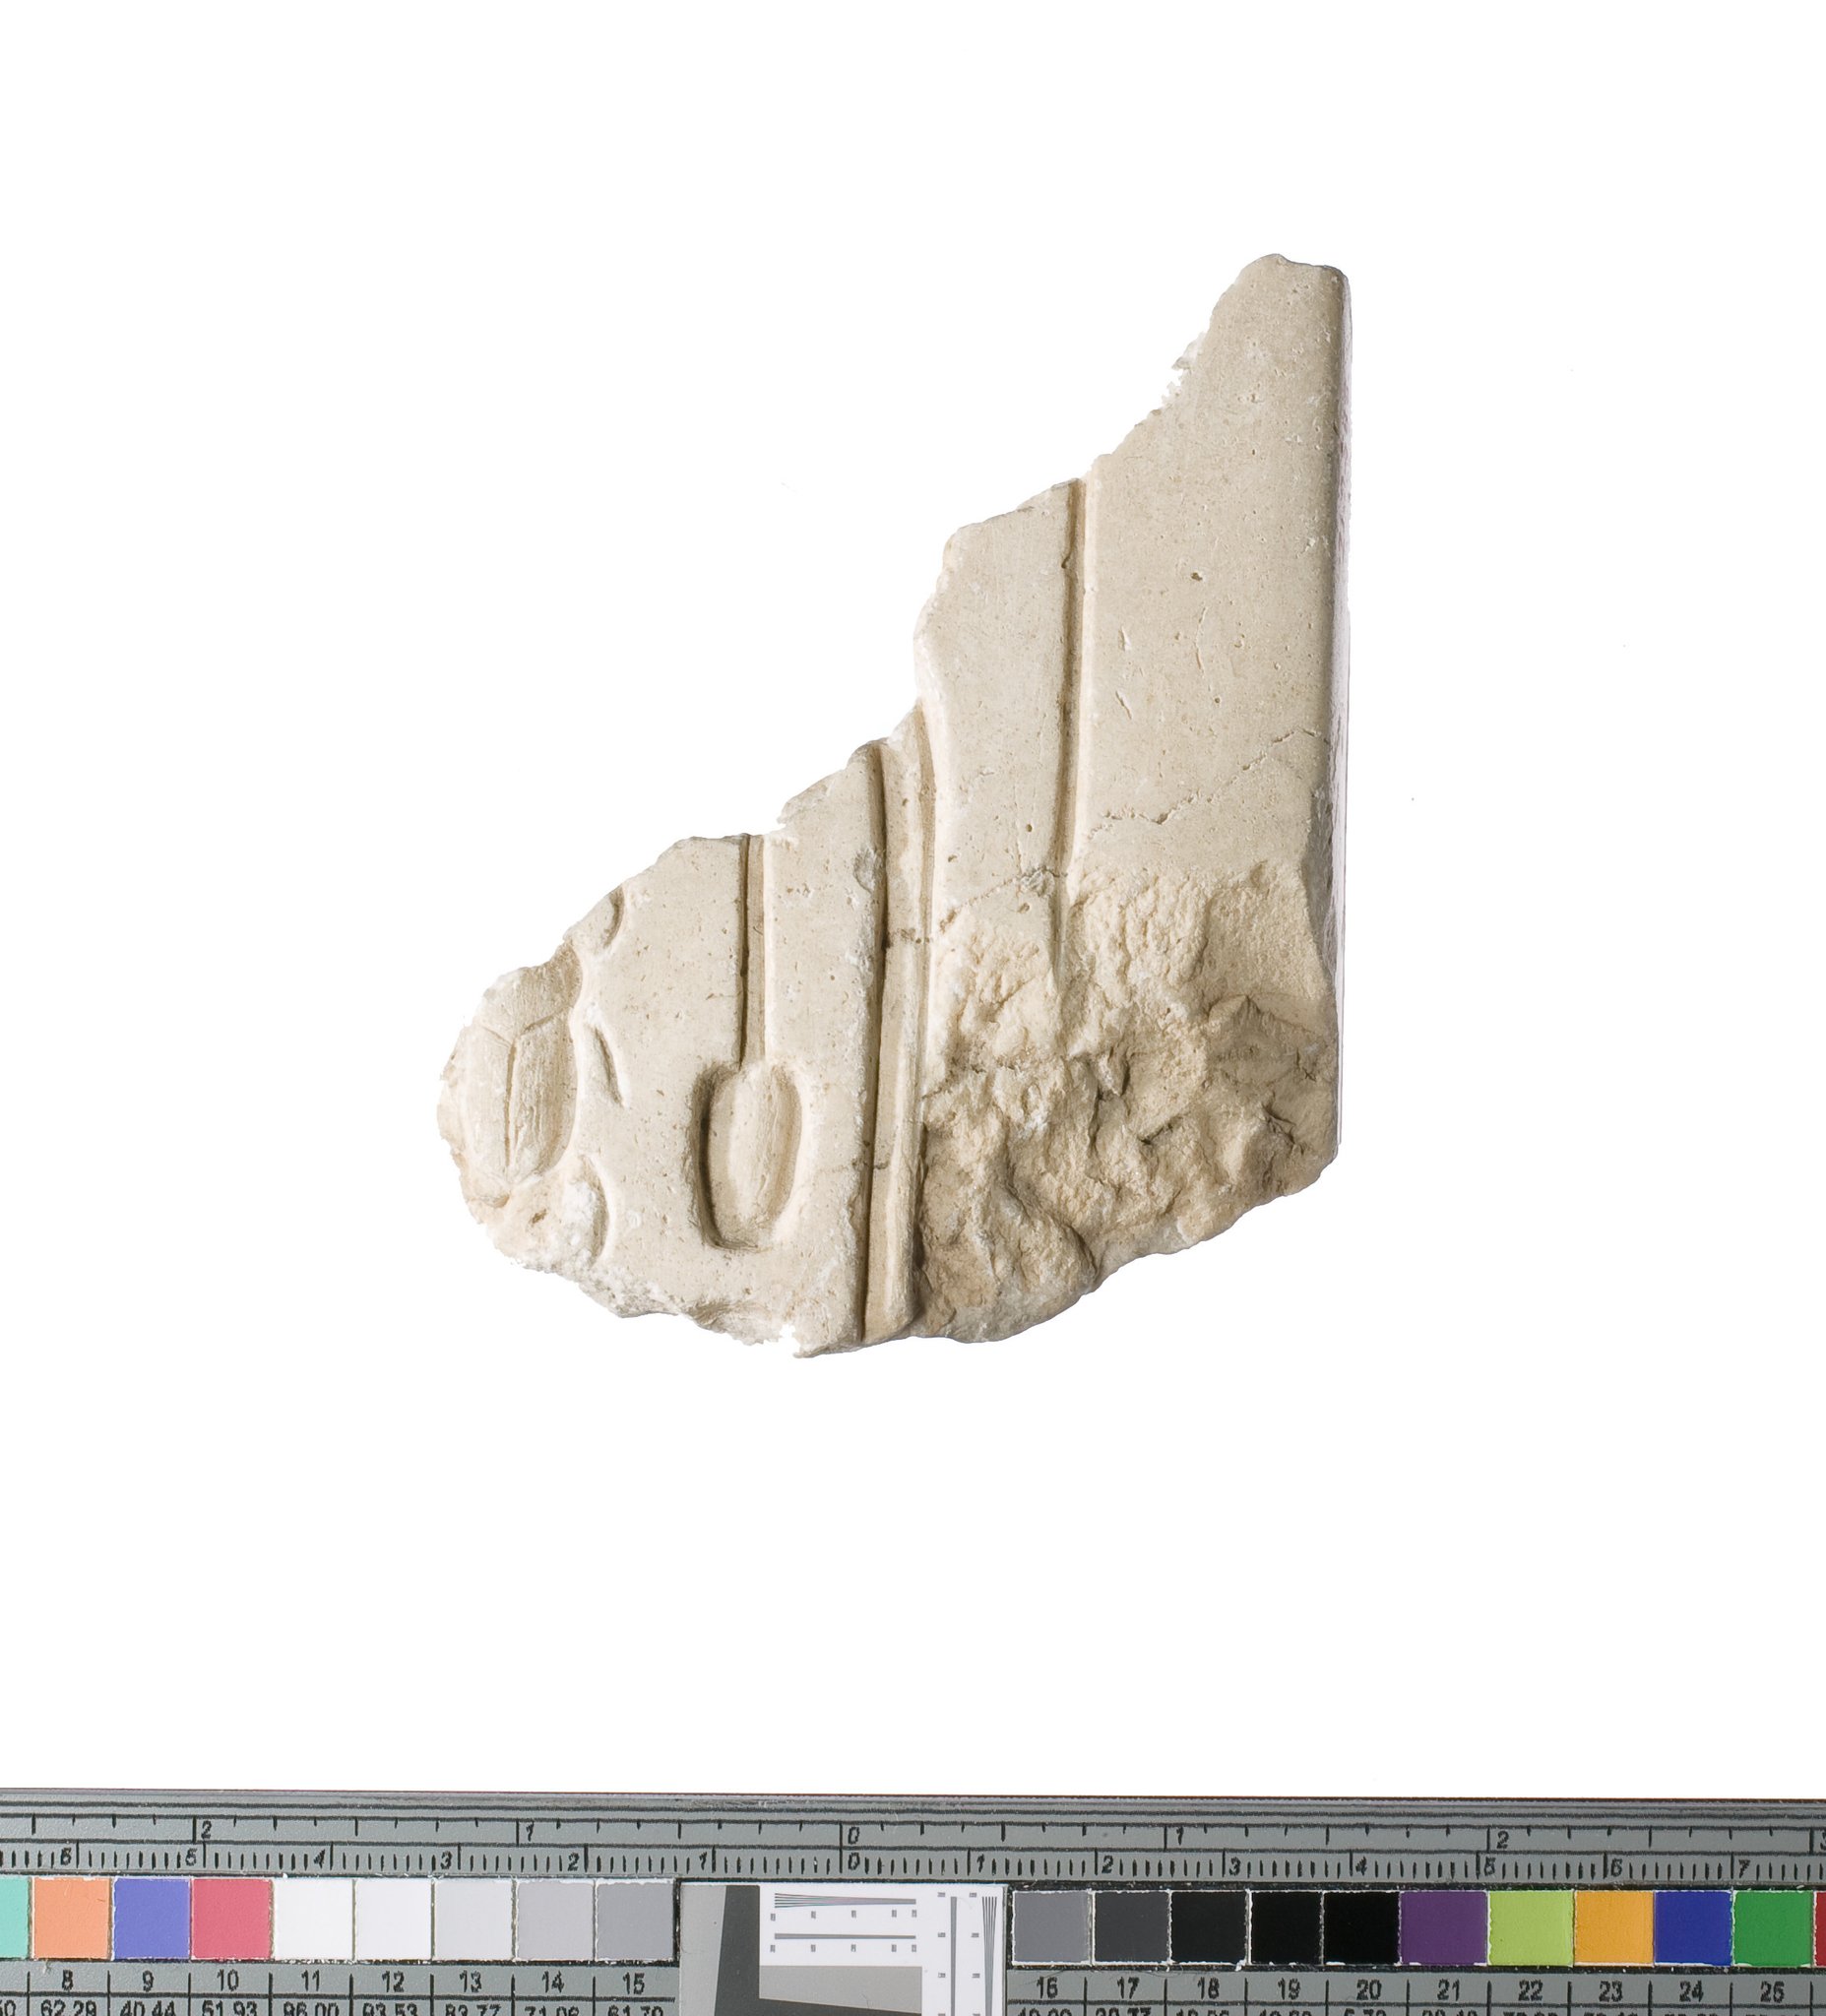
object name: inscribed corner element, aten cartouche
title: Inscribed corner, Akhenaten prenomen on one surface, Aten cartouche on other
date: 1353-1336 BCE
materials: limestone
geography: egypt